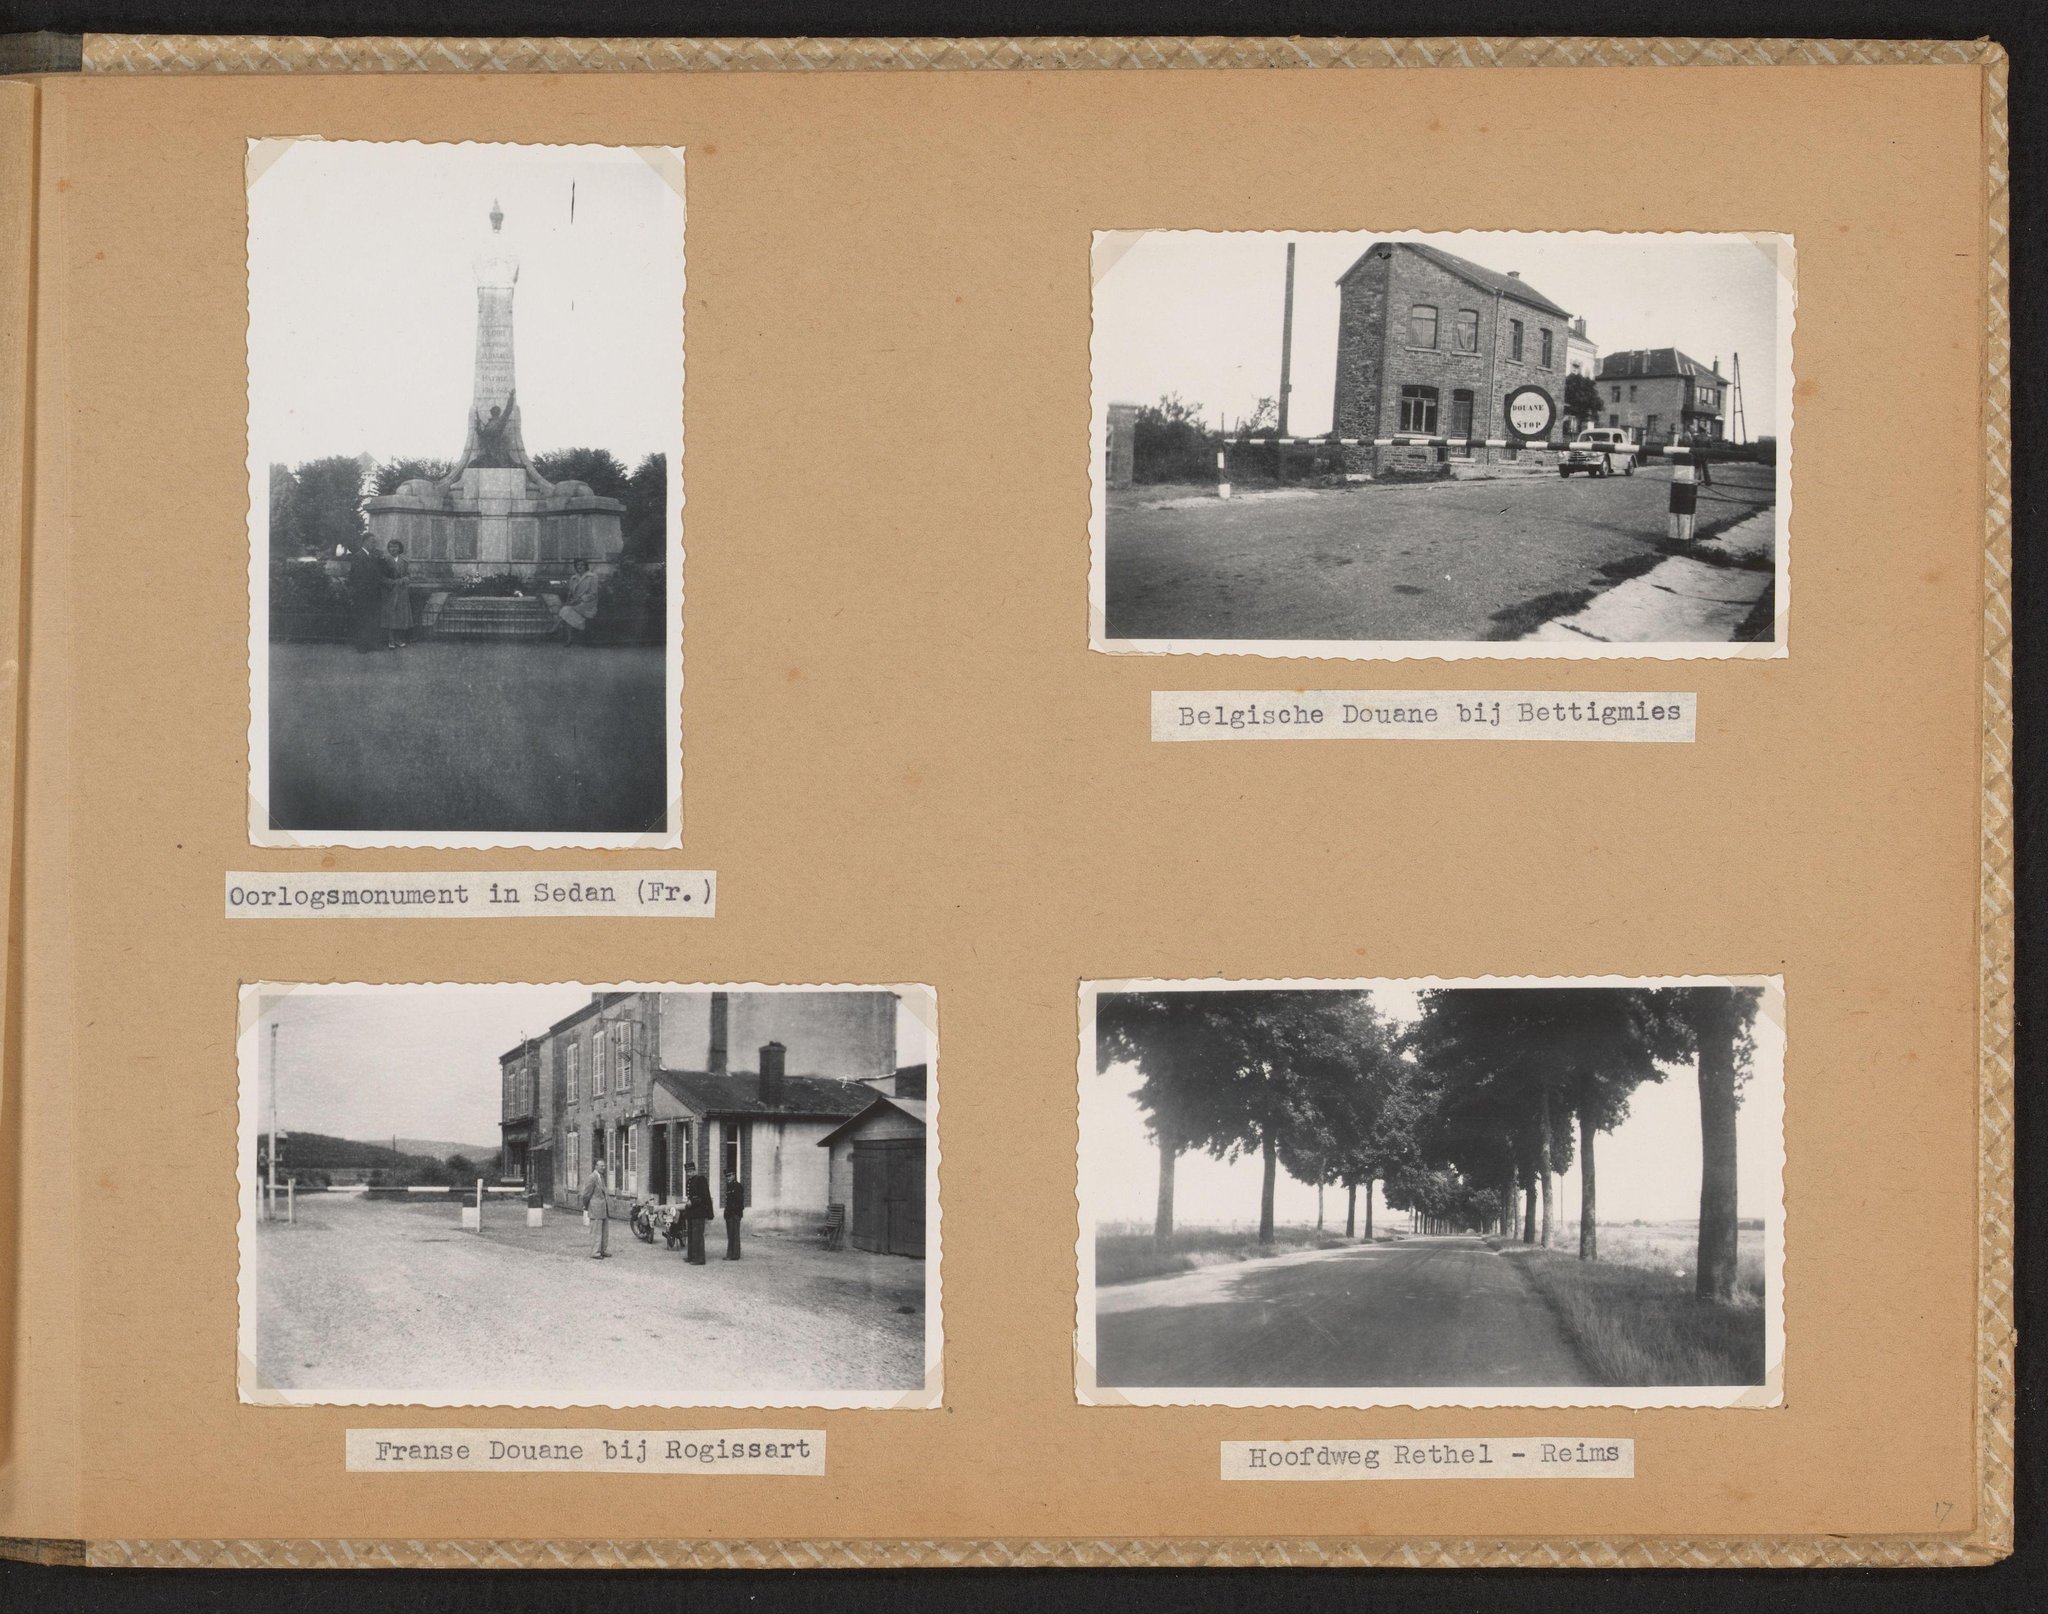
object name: album leaf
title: Noord-Frankrijk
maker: Anonymous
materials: paper, photographic support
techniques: gelatin silver print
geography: france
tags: the family travelling, on holiday, outing, pleasure trip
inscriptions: inscription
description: Albumblad met vier foto's onderweg in Noord-Frankrijk, o.a. bij Sedan. Onder de foto's uitgeknipte papiertjes met getypte opschriften. Onderdeel van het tweede fotoalbum met foto's van familievakanties in Nederland, België, Luxemburg en Frankrijk in 1950-1951.